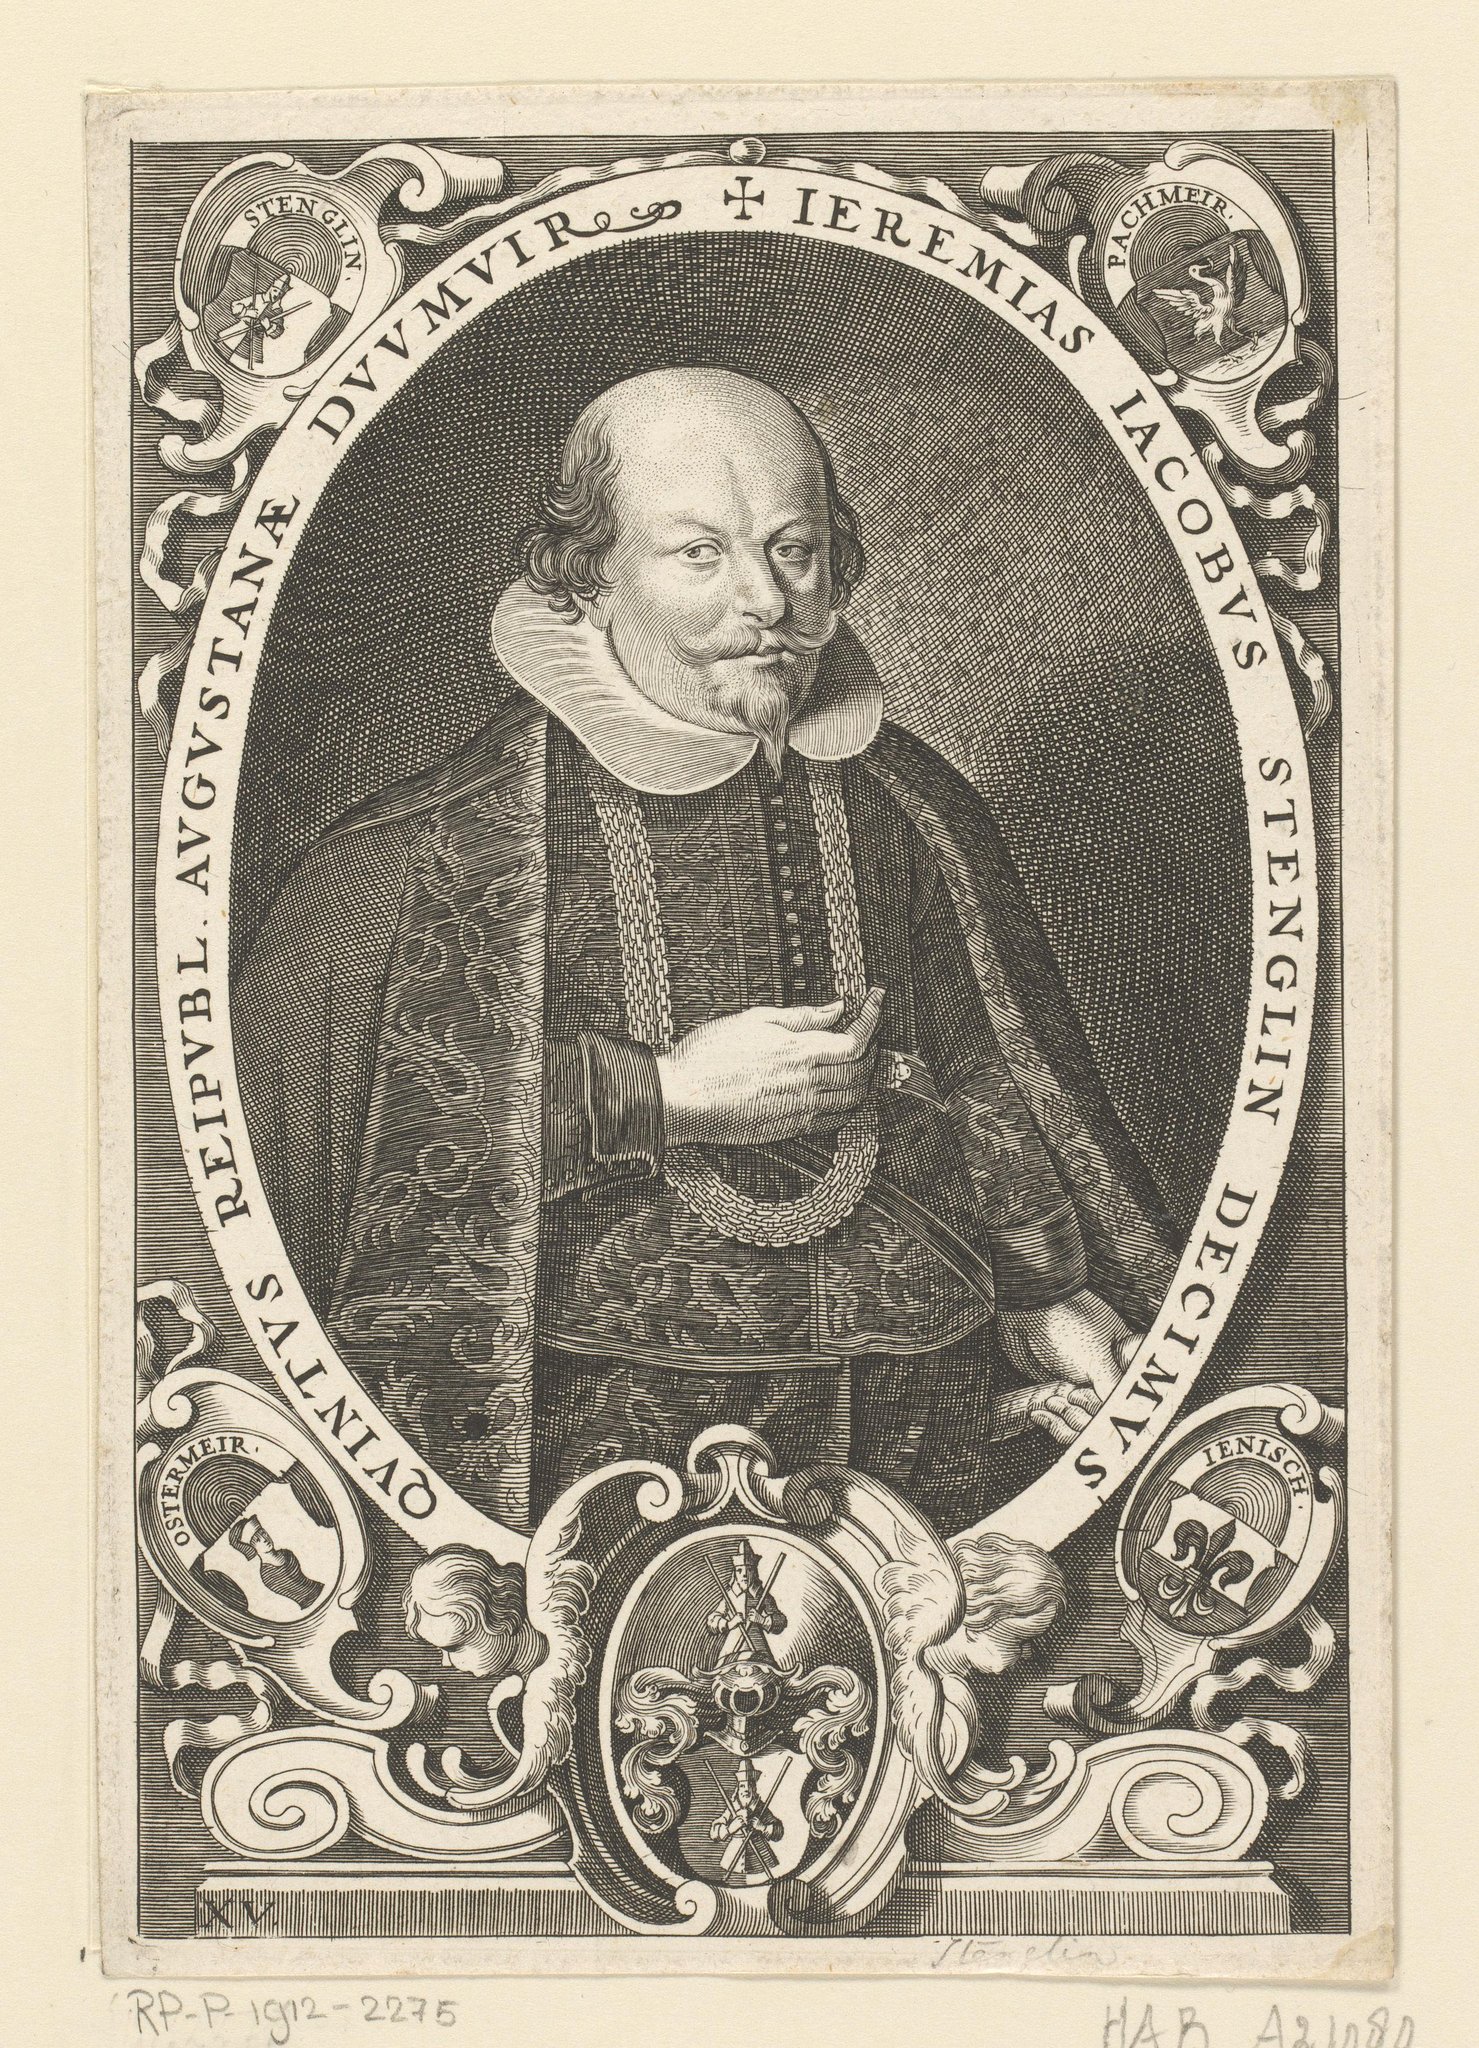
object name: print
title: Portret van Jeremias Jacobus Stenglin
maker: lucas kilian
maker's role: draughtsman, print maker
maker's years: 1579-1637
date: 1624-1637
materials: paper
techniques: engraving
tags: historical persons, book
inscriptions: collector's mark: Lugt 2228